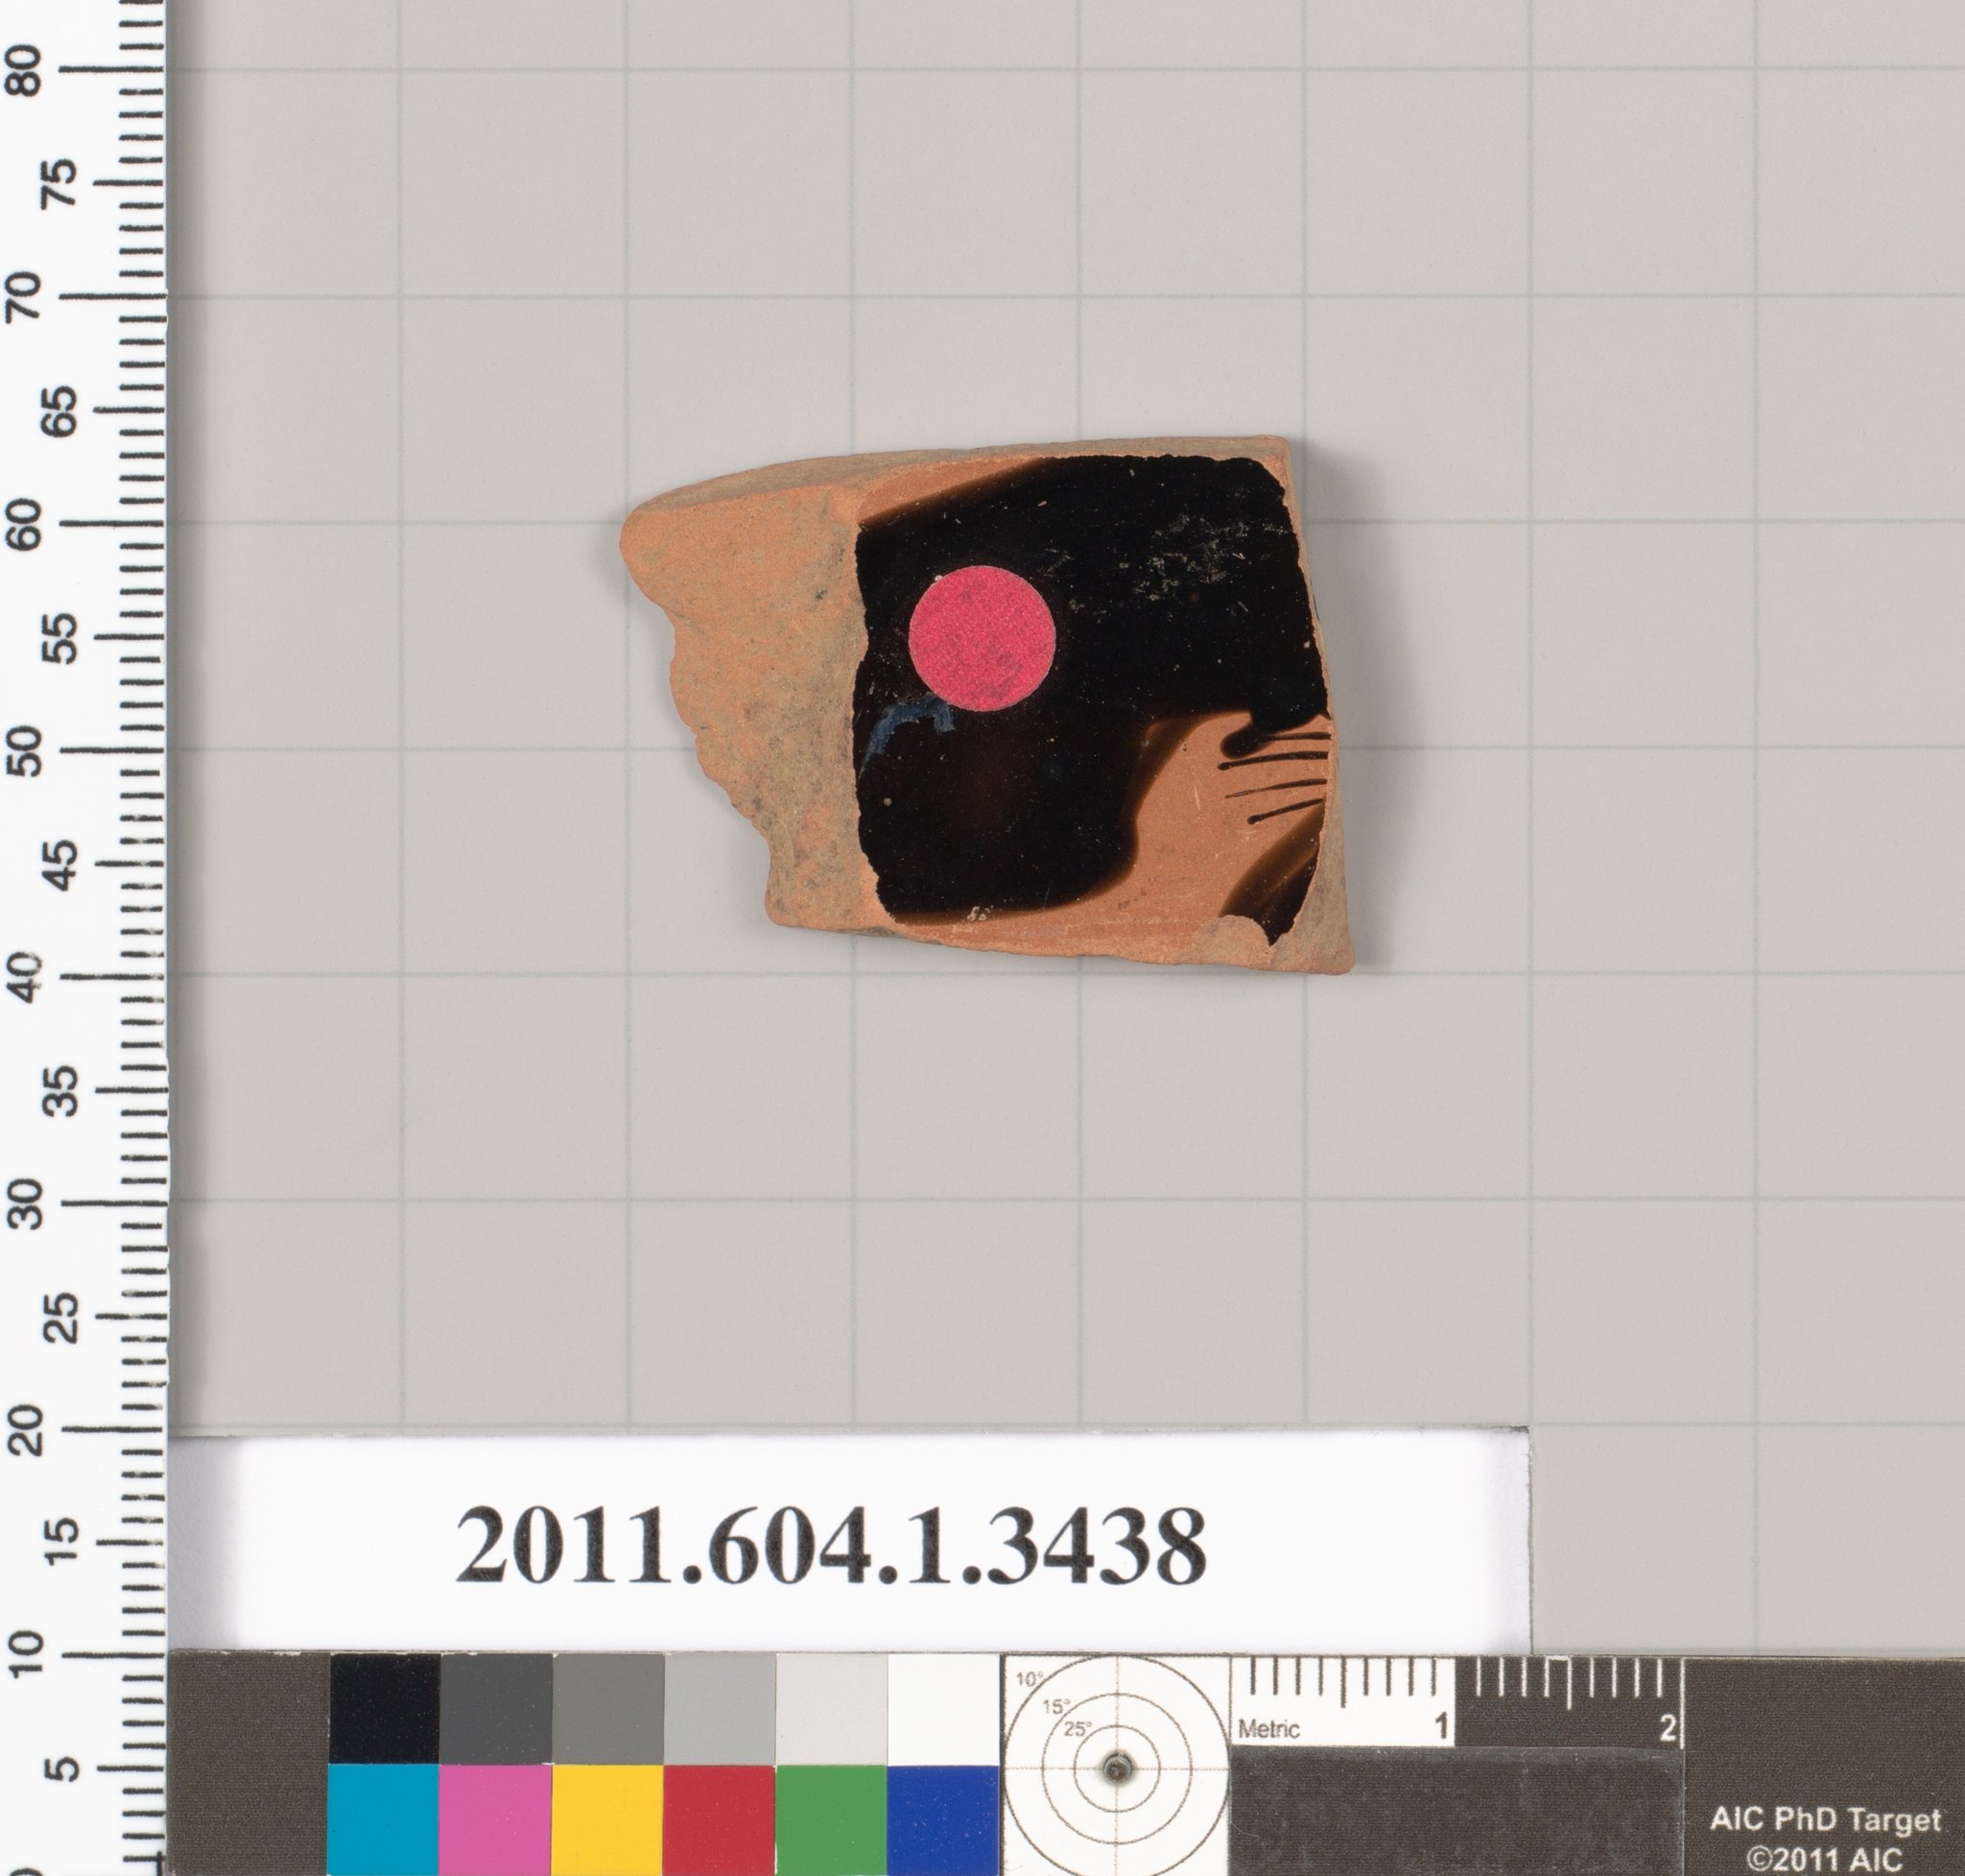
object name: kylix fragment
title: Terracotta fragment of a kylix (drinking cup)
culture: greek, attic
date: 467-435 BCE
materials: terracotta